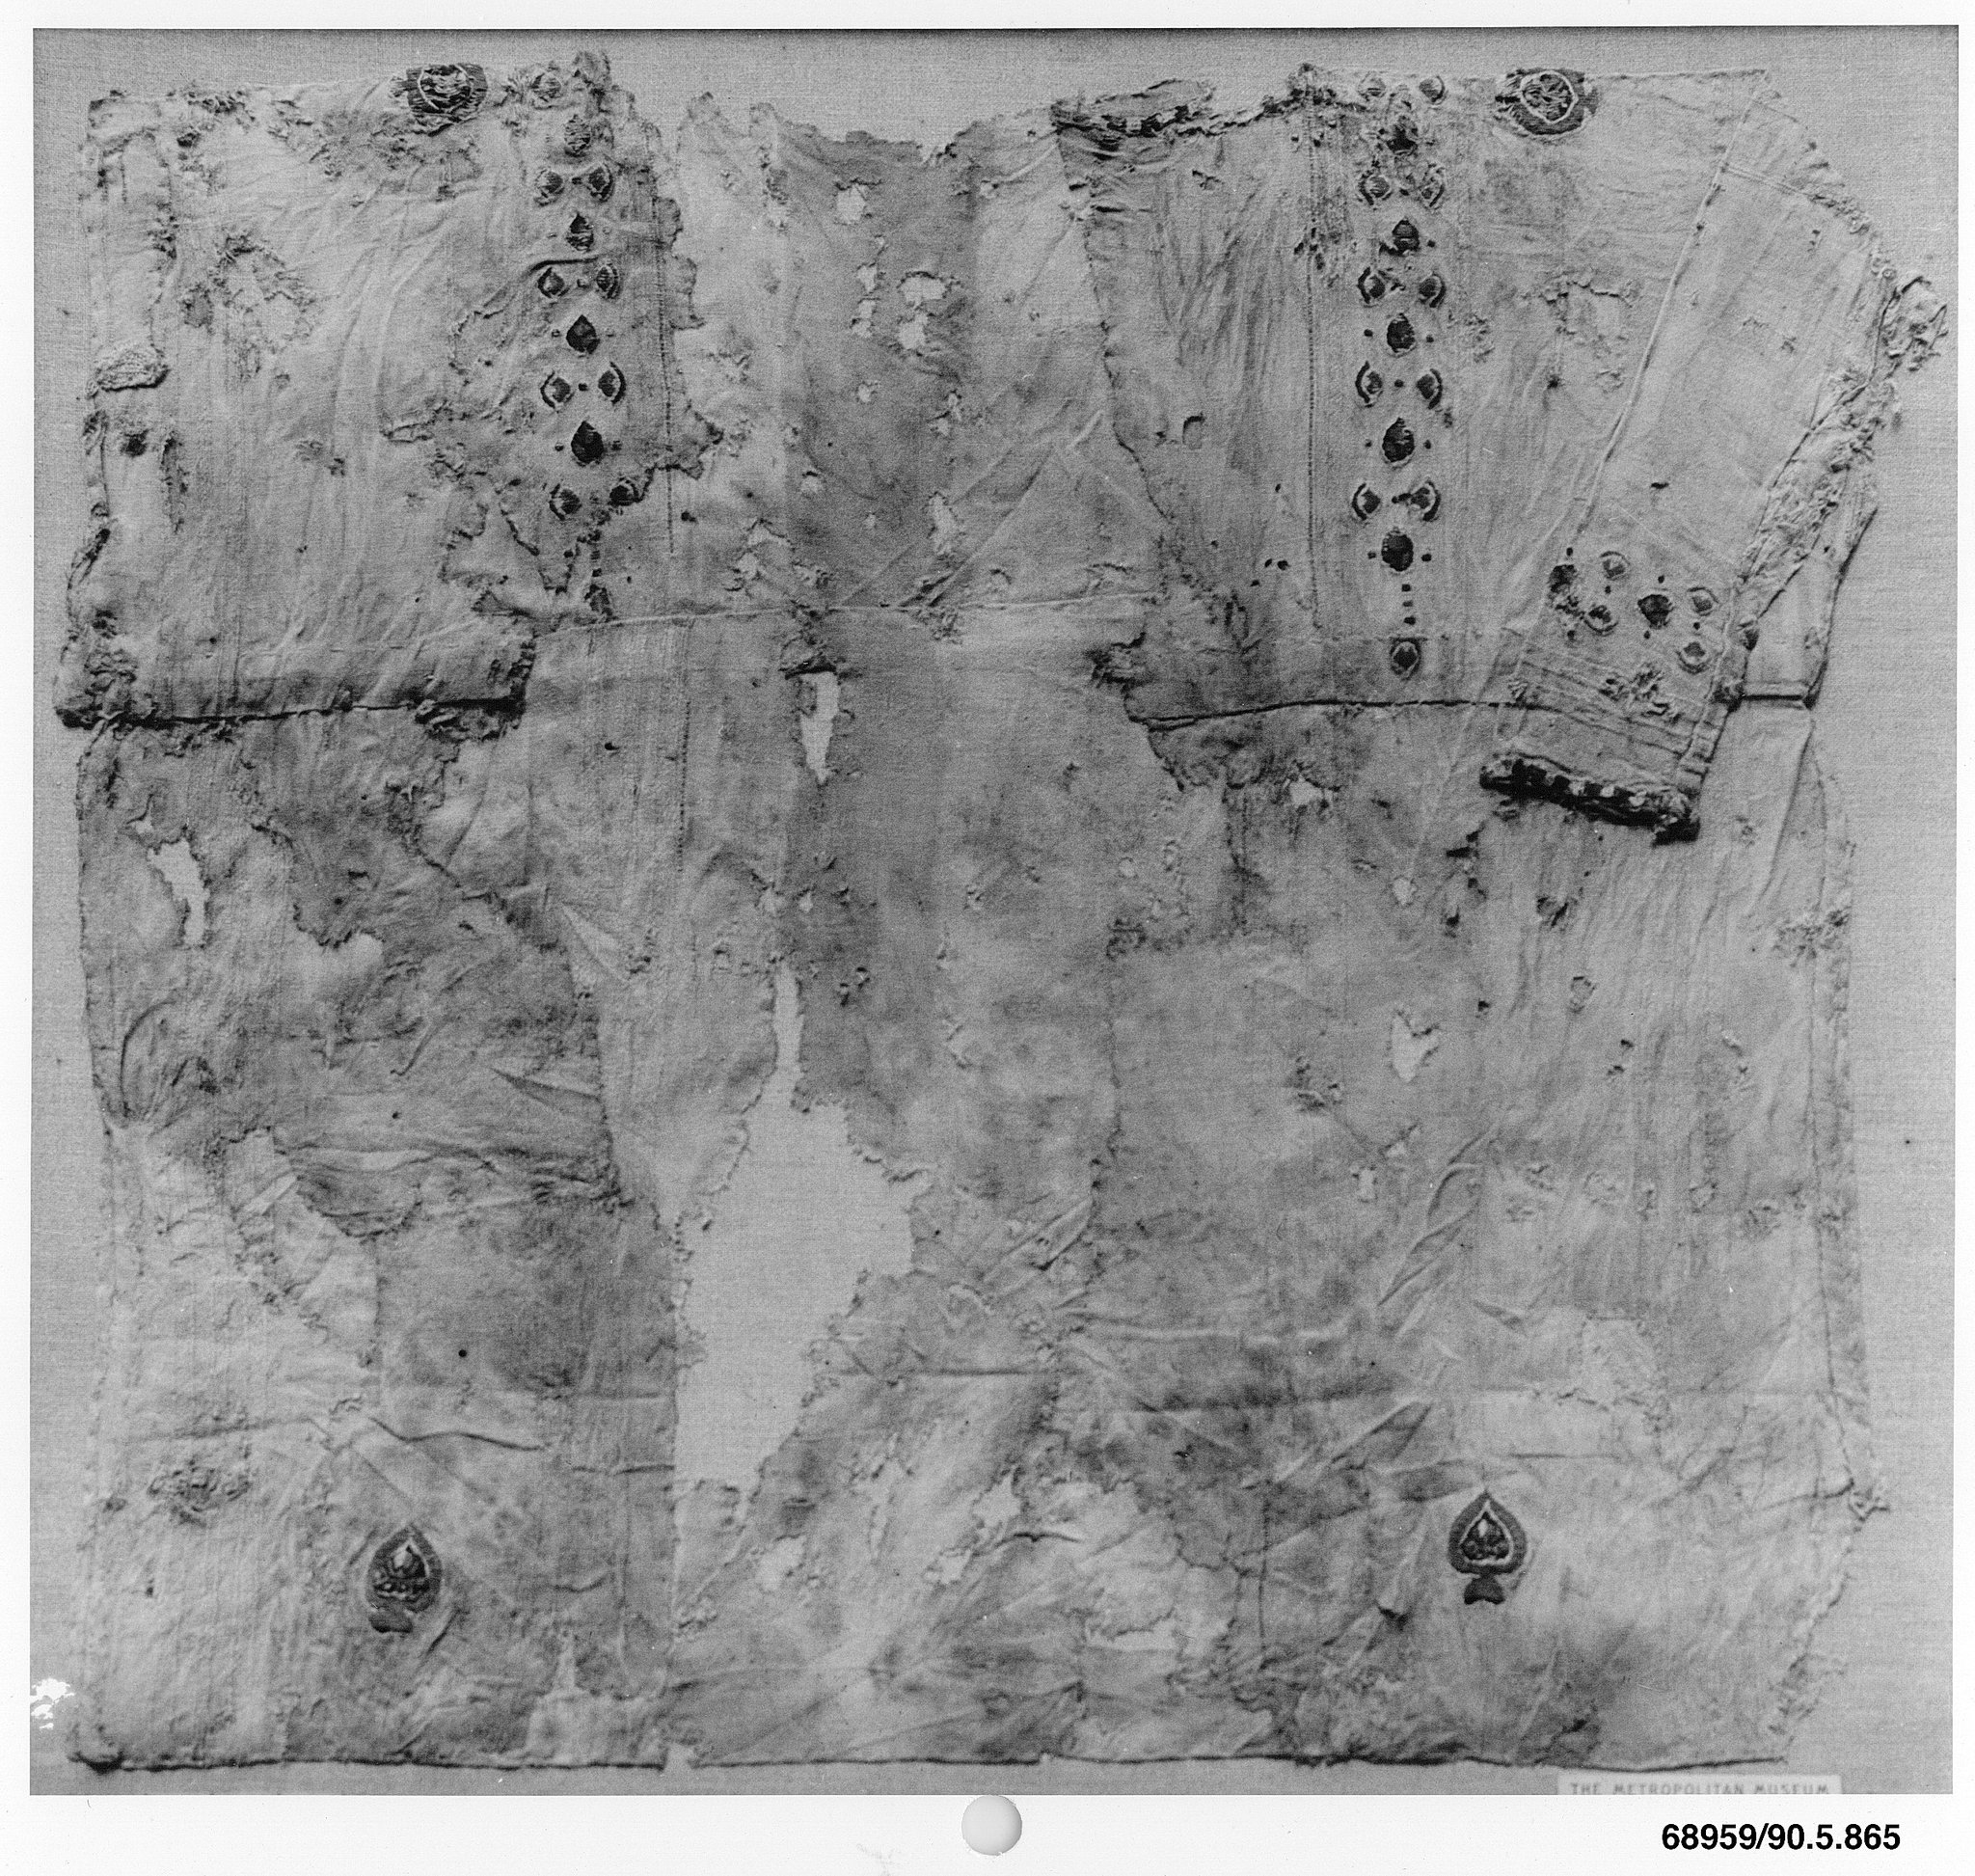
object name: tunic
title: Child's Tunic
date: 401-600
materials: linen, wool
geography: egypt